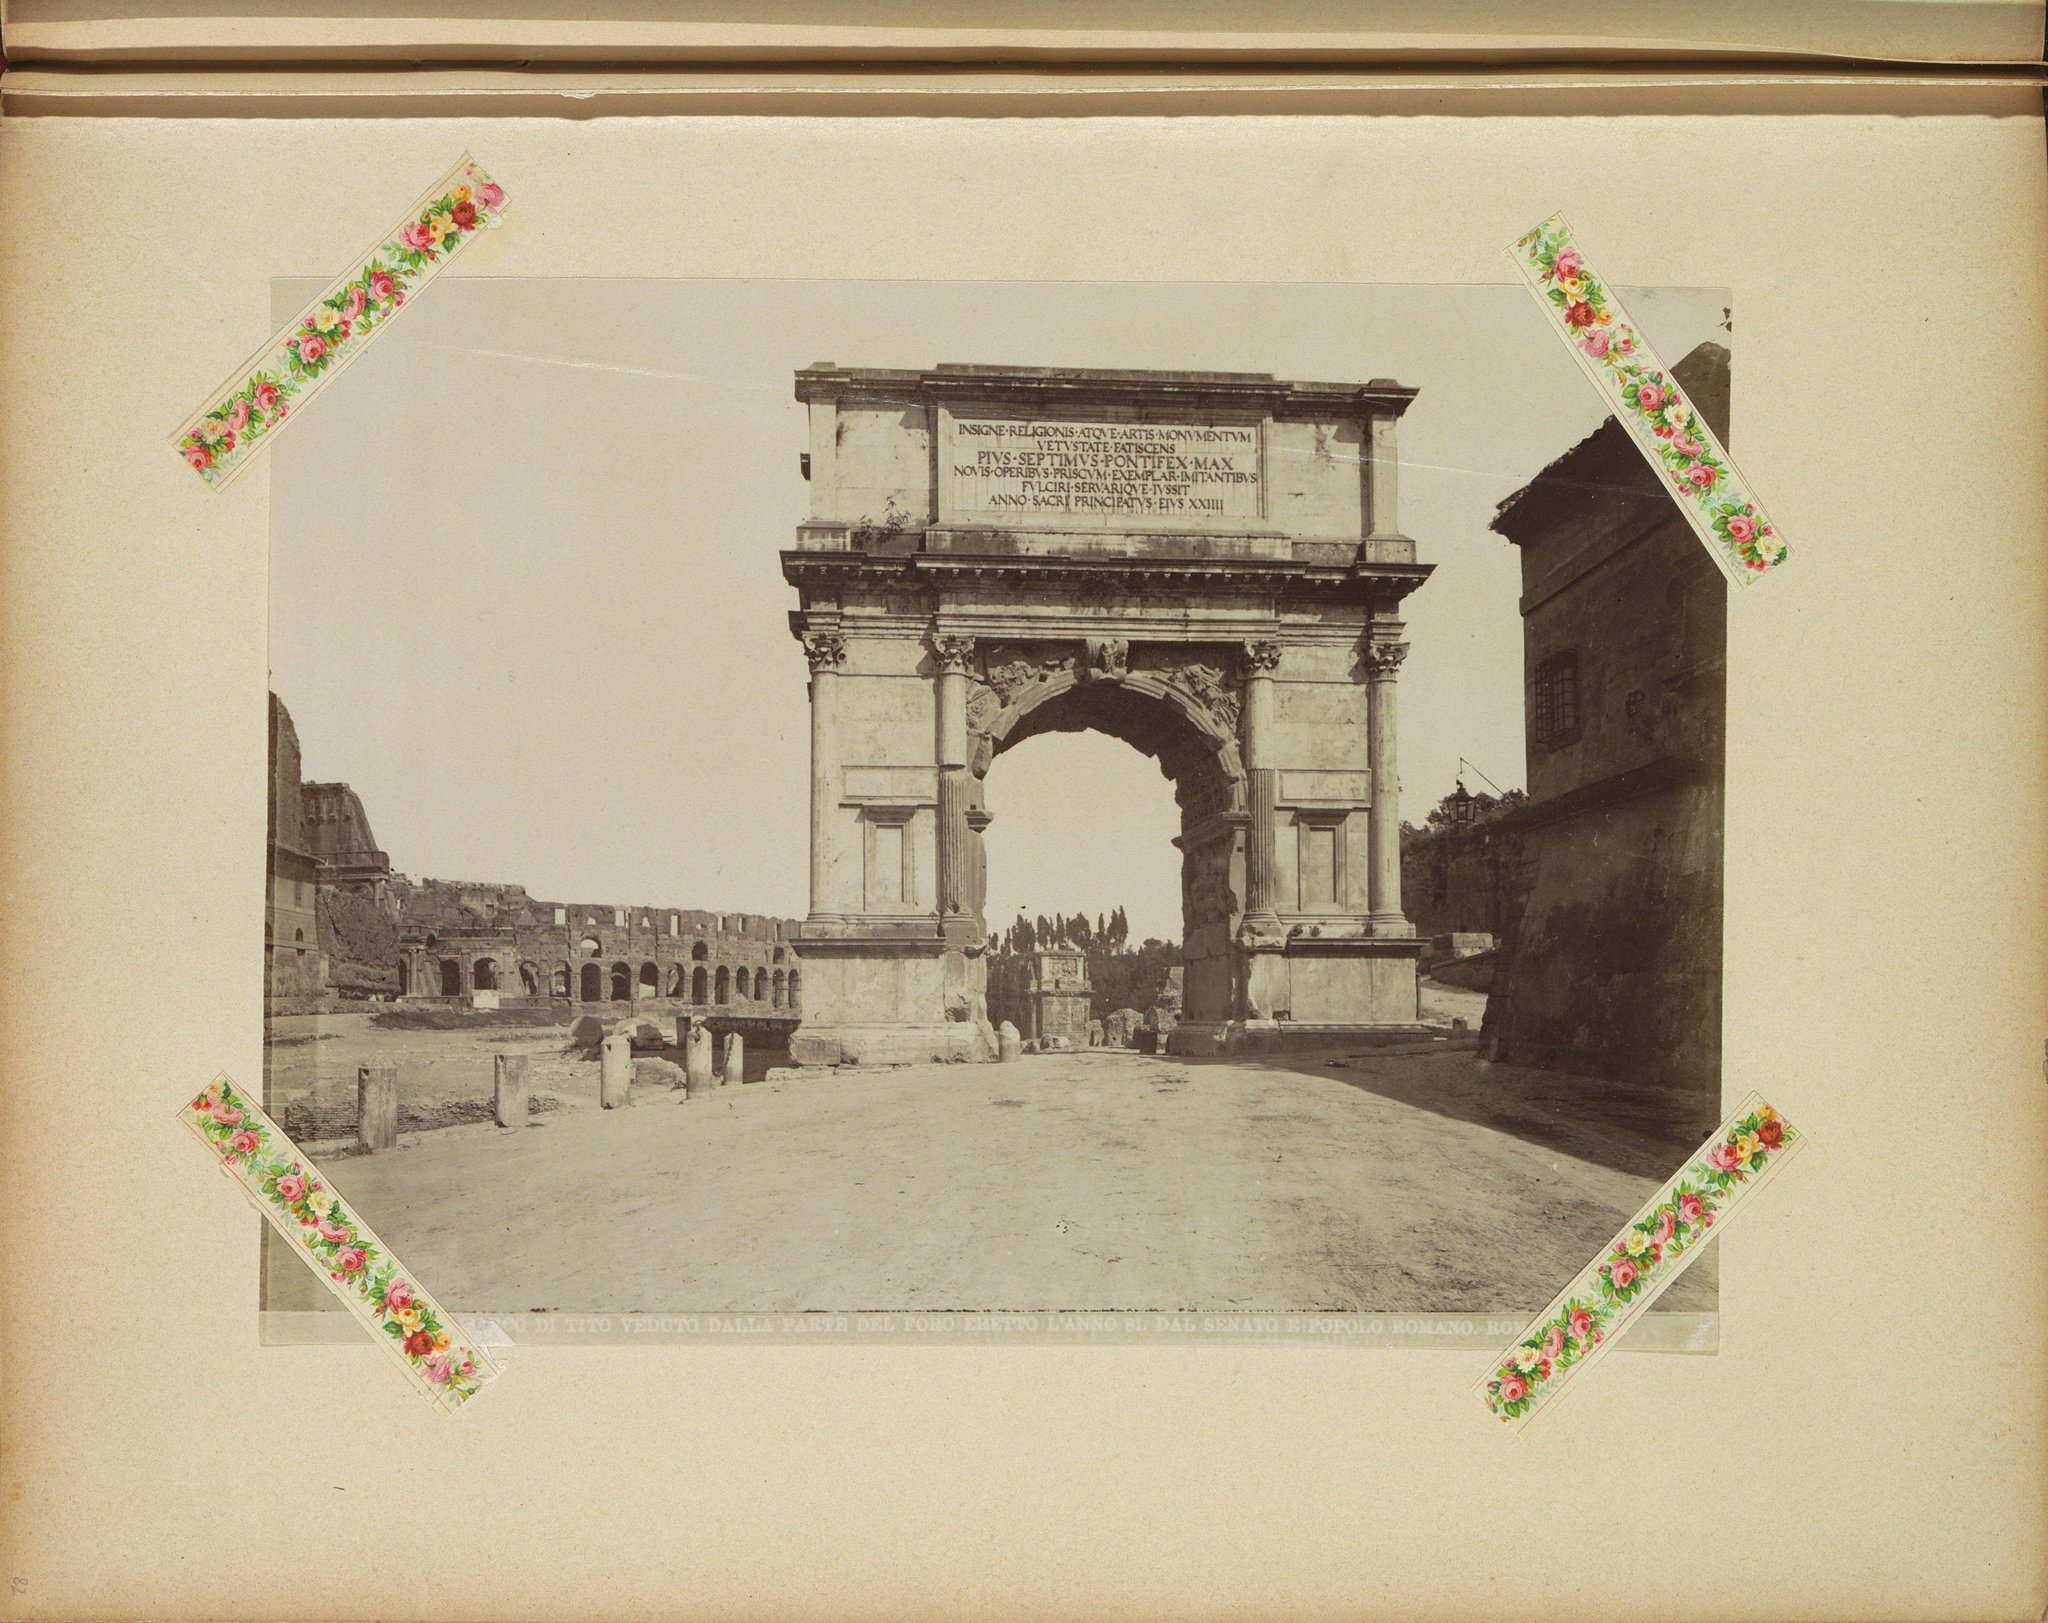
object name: photograph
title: Boog van Titus op het Forum Romanum in Rome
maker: Anonymous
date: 1860-1900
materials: photographic support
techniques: albumen print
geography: forum romanum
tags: triumphal arch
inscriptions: number: ‘119’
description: Onderdeel van Fotoalbum met opnames van bezienswaardigheden in Italiaanse steden en van kunstwerken.